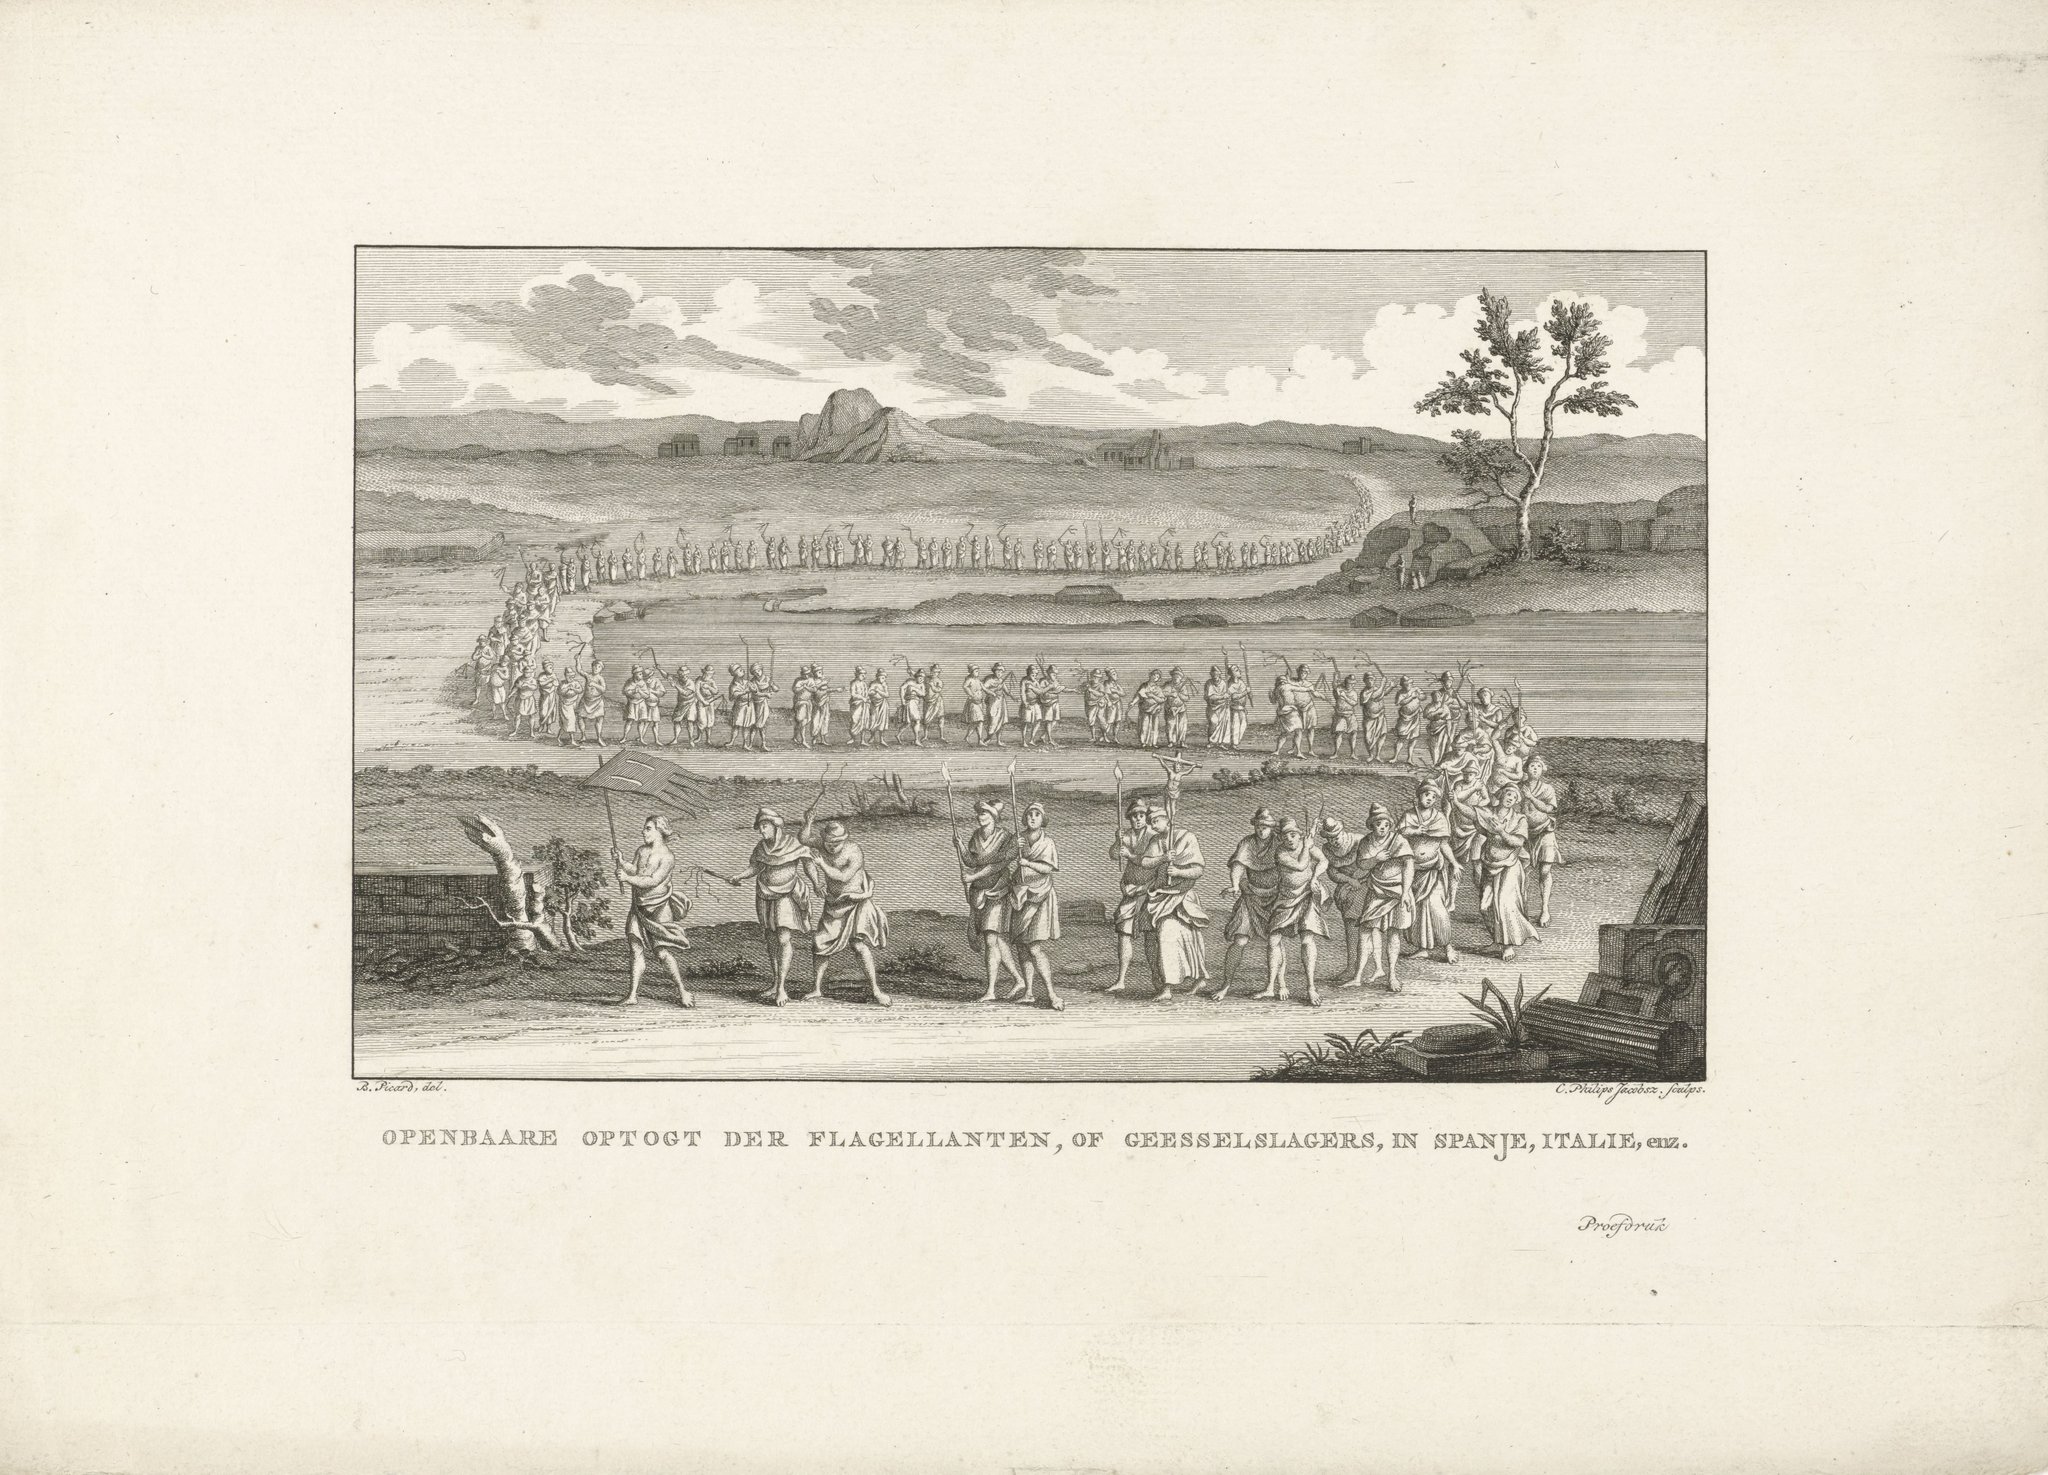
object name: print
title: Openbaare Optogt der flagellanten, of geesselslagers, in Spanje, Italie, enz.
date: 1752-1789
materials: paper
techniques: etching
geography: amsterdam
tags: flagellants ~ ascetic life, self-castigation ~ ascetic life, procession ~ christian religion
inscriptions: collector's mark: Lugt 2228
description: Landschap met processie van flagellanten. Dit waren gelovigen die zichzelf ritueel geselden.